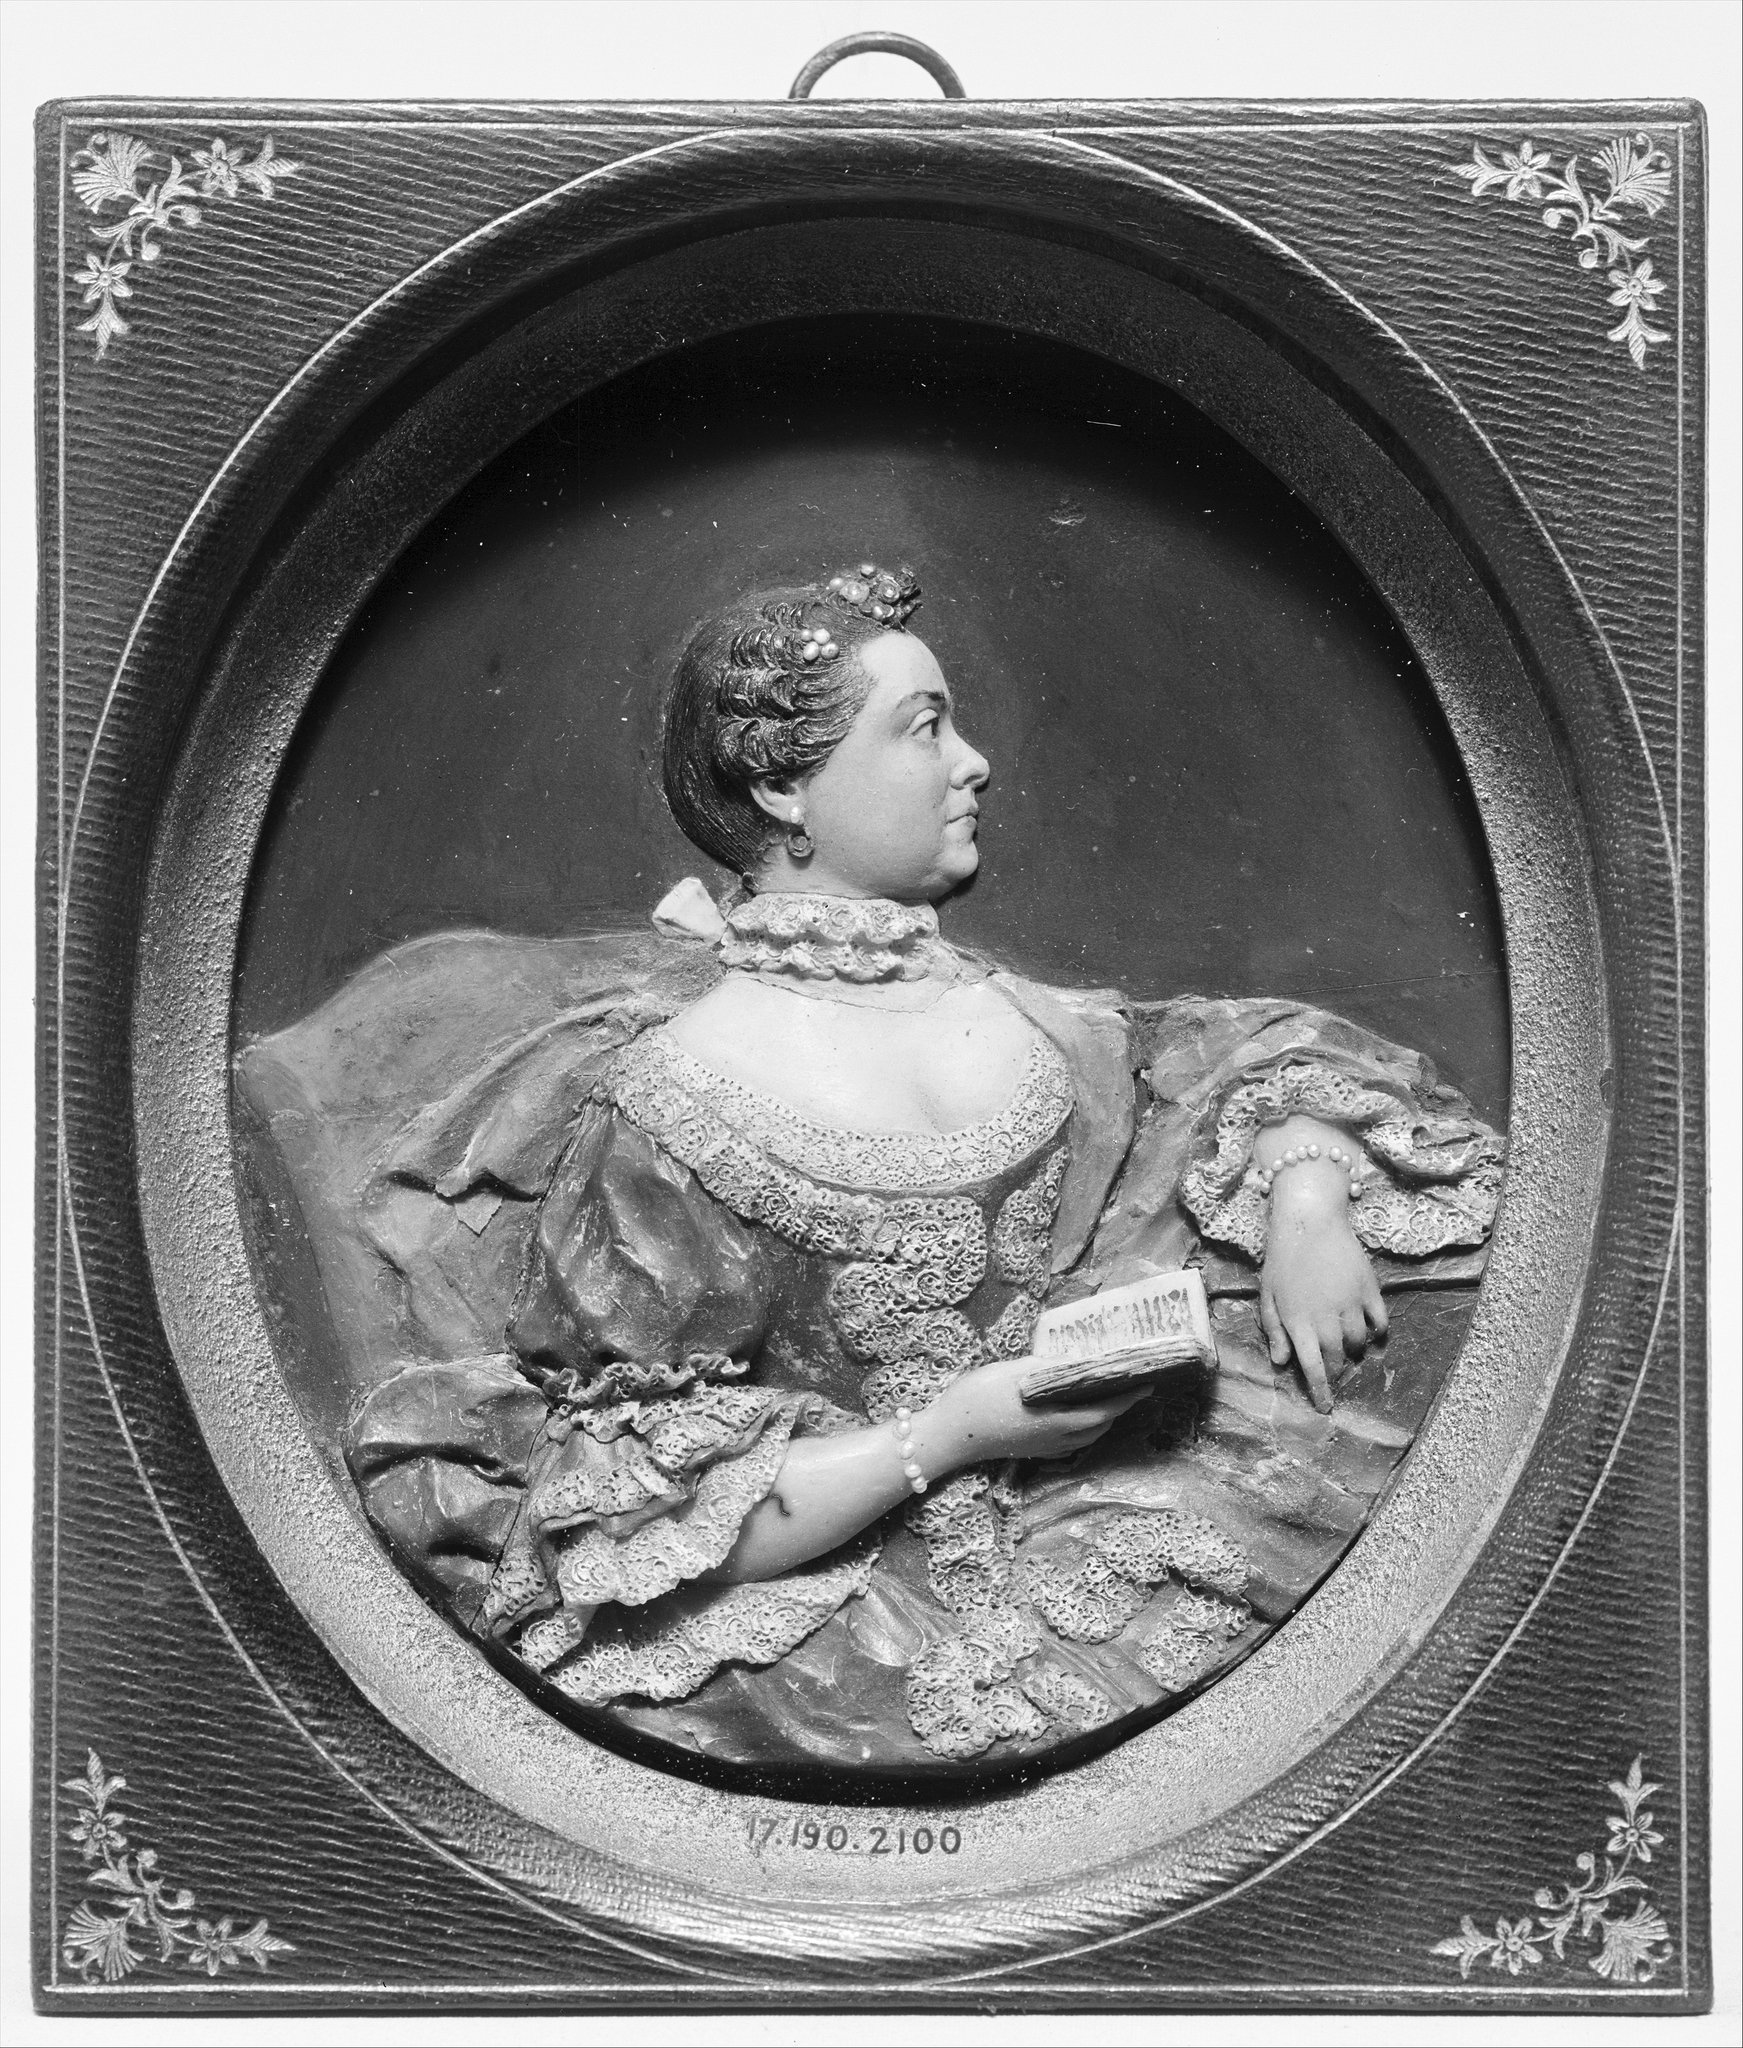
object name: portrait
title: Portrait of a seated lady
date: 1701-1800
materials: wax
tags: portraits,women